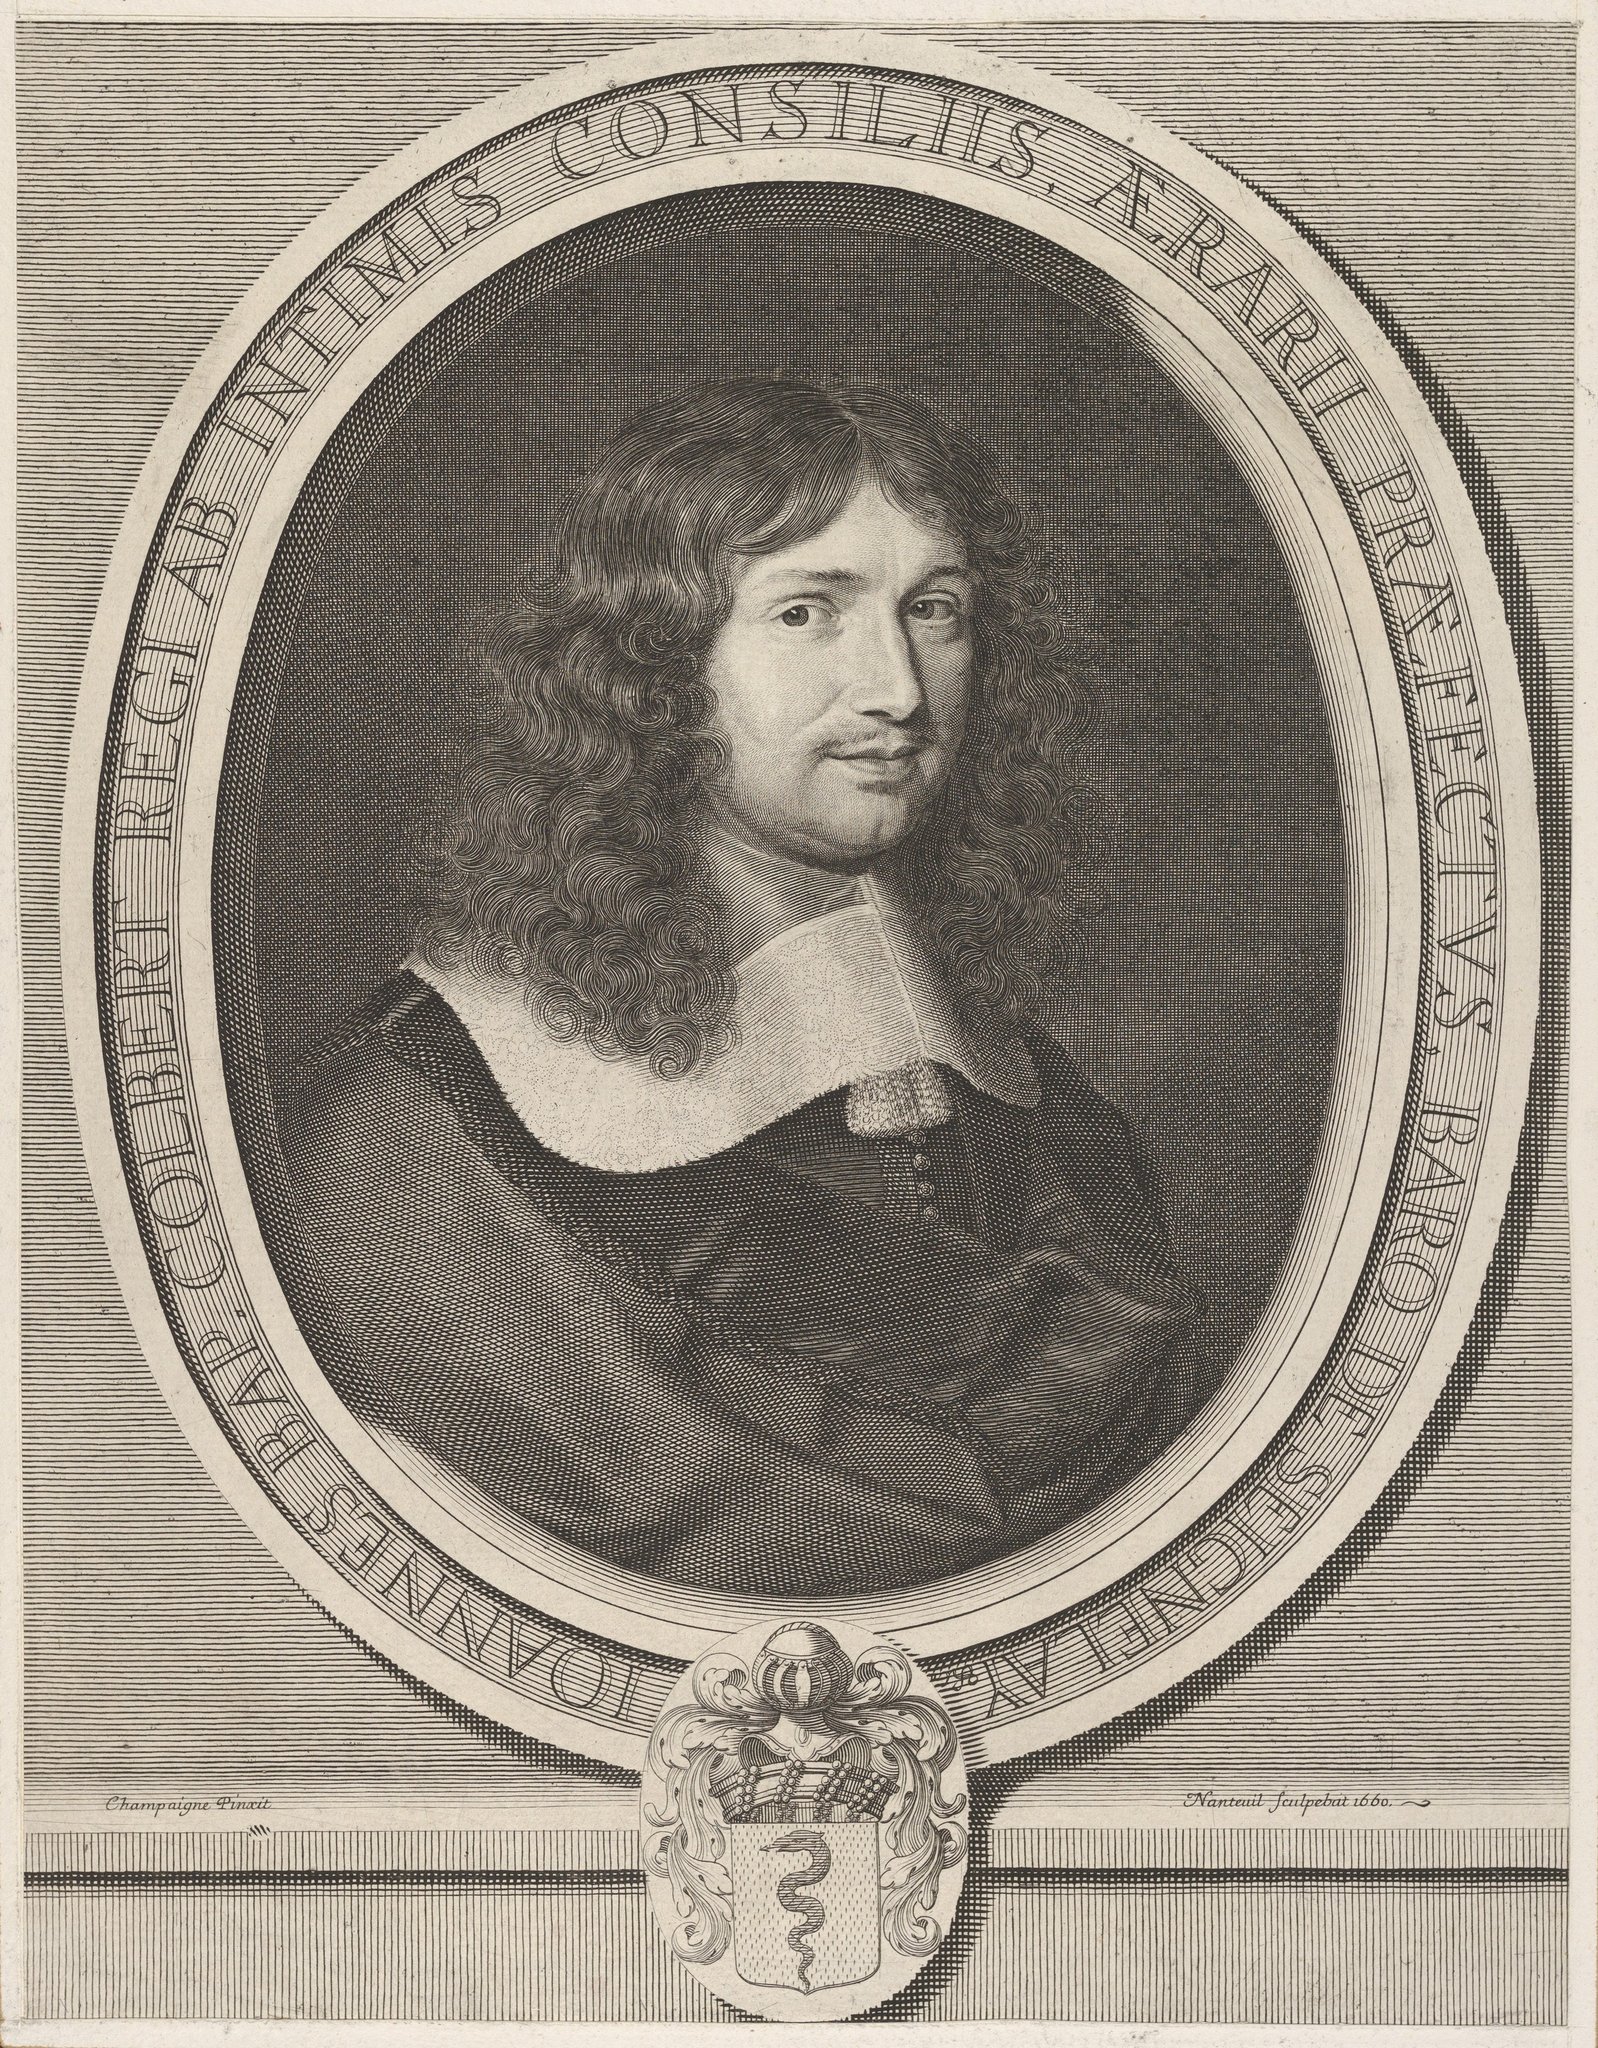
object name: print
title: Jean-Baptiste Colbert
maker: robert nanteuil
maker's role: artist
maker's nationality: french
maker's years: 1623-1678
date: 1660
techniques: engraving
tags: men,portraits,coat of arms